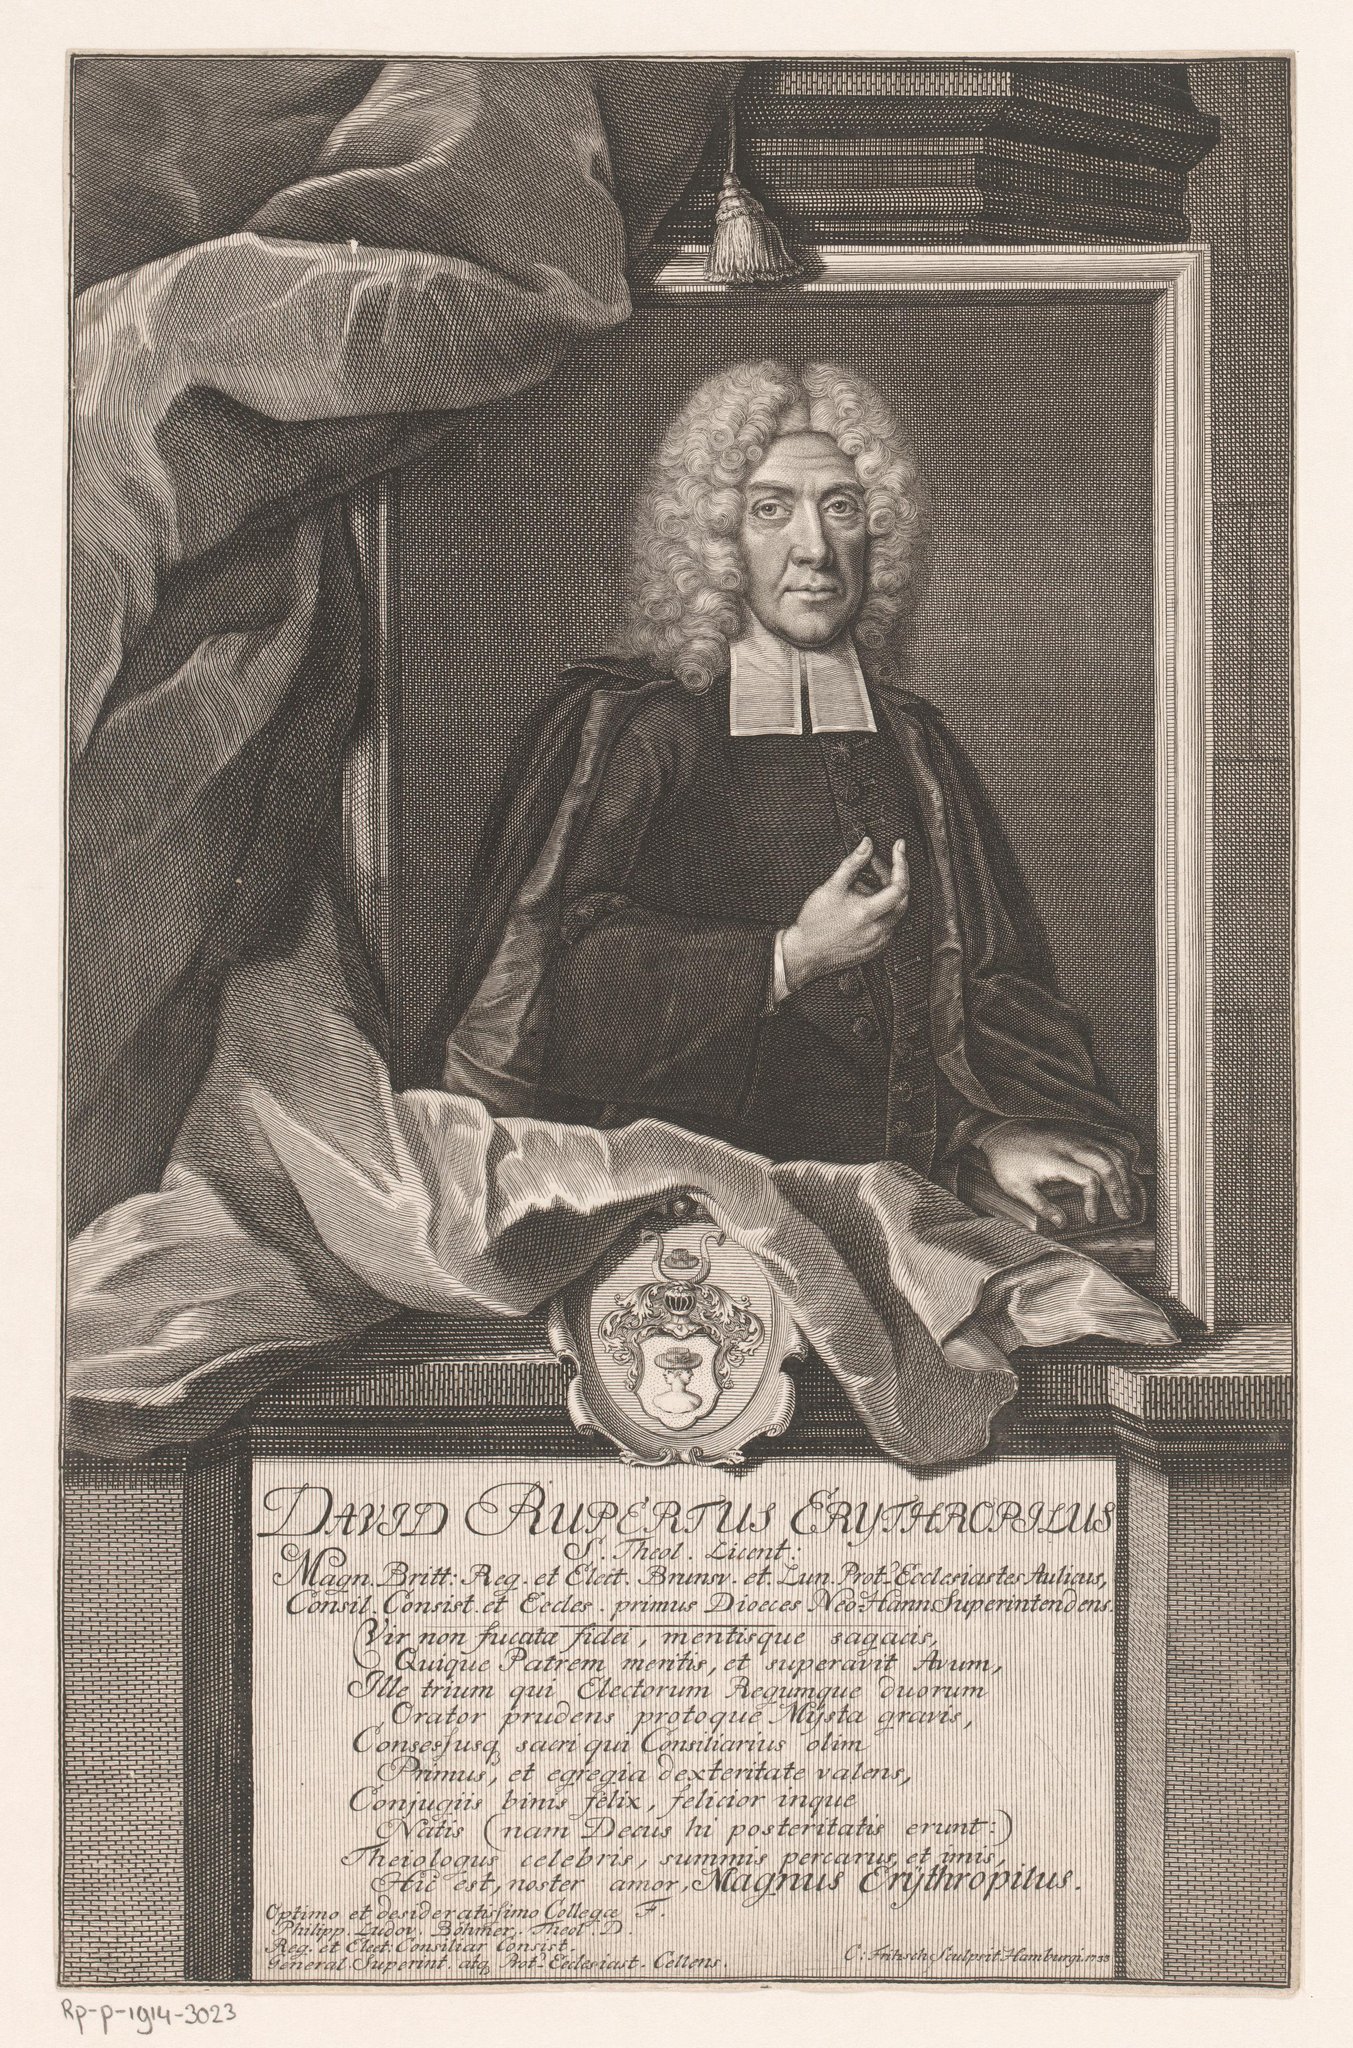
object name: print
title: Portret van David Rupert Erythropel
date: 1733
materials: paper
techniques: engraving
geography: hamburg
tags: david rupert erythropel, theologian, historical persons, book, armorial bearing, heraldry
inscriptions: collector's mark: Lugt 2228